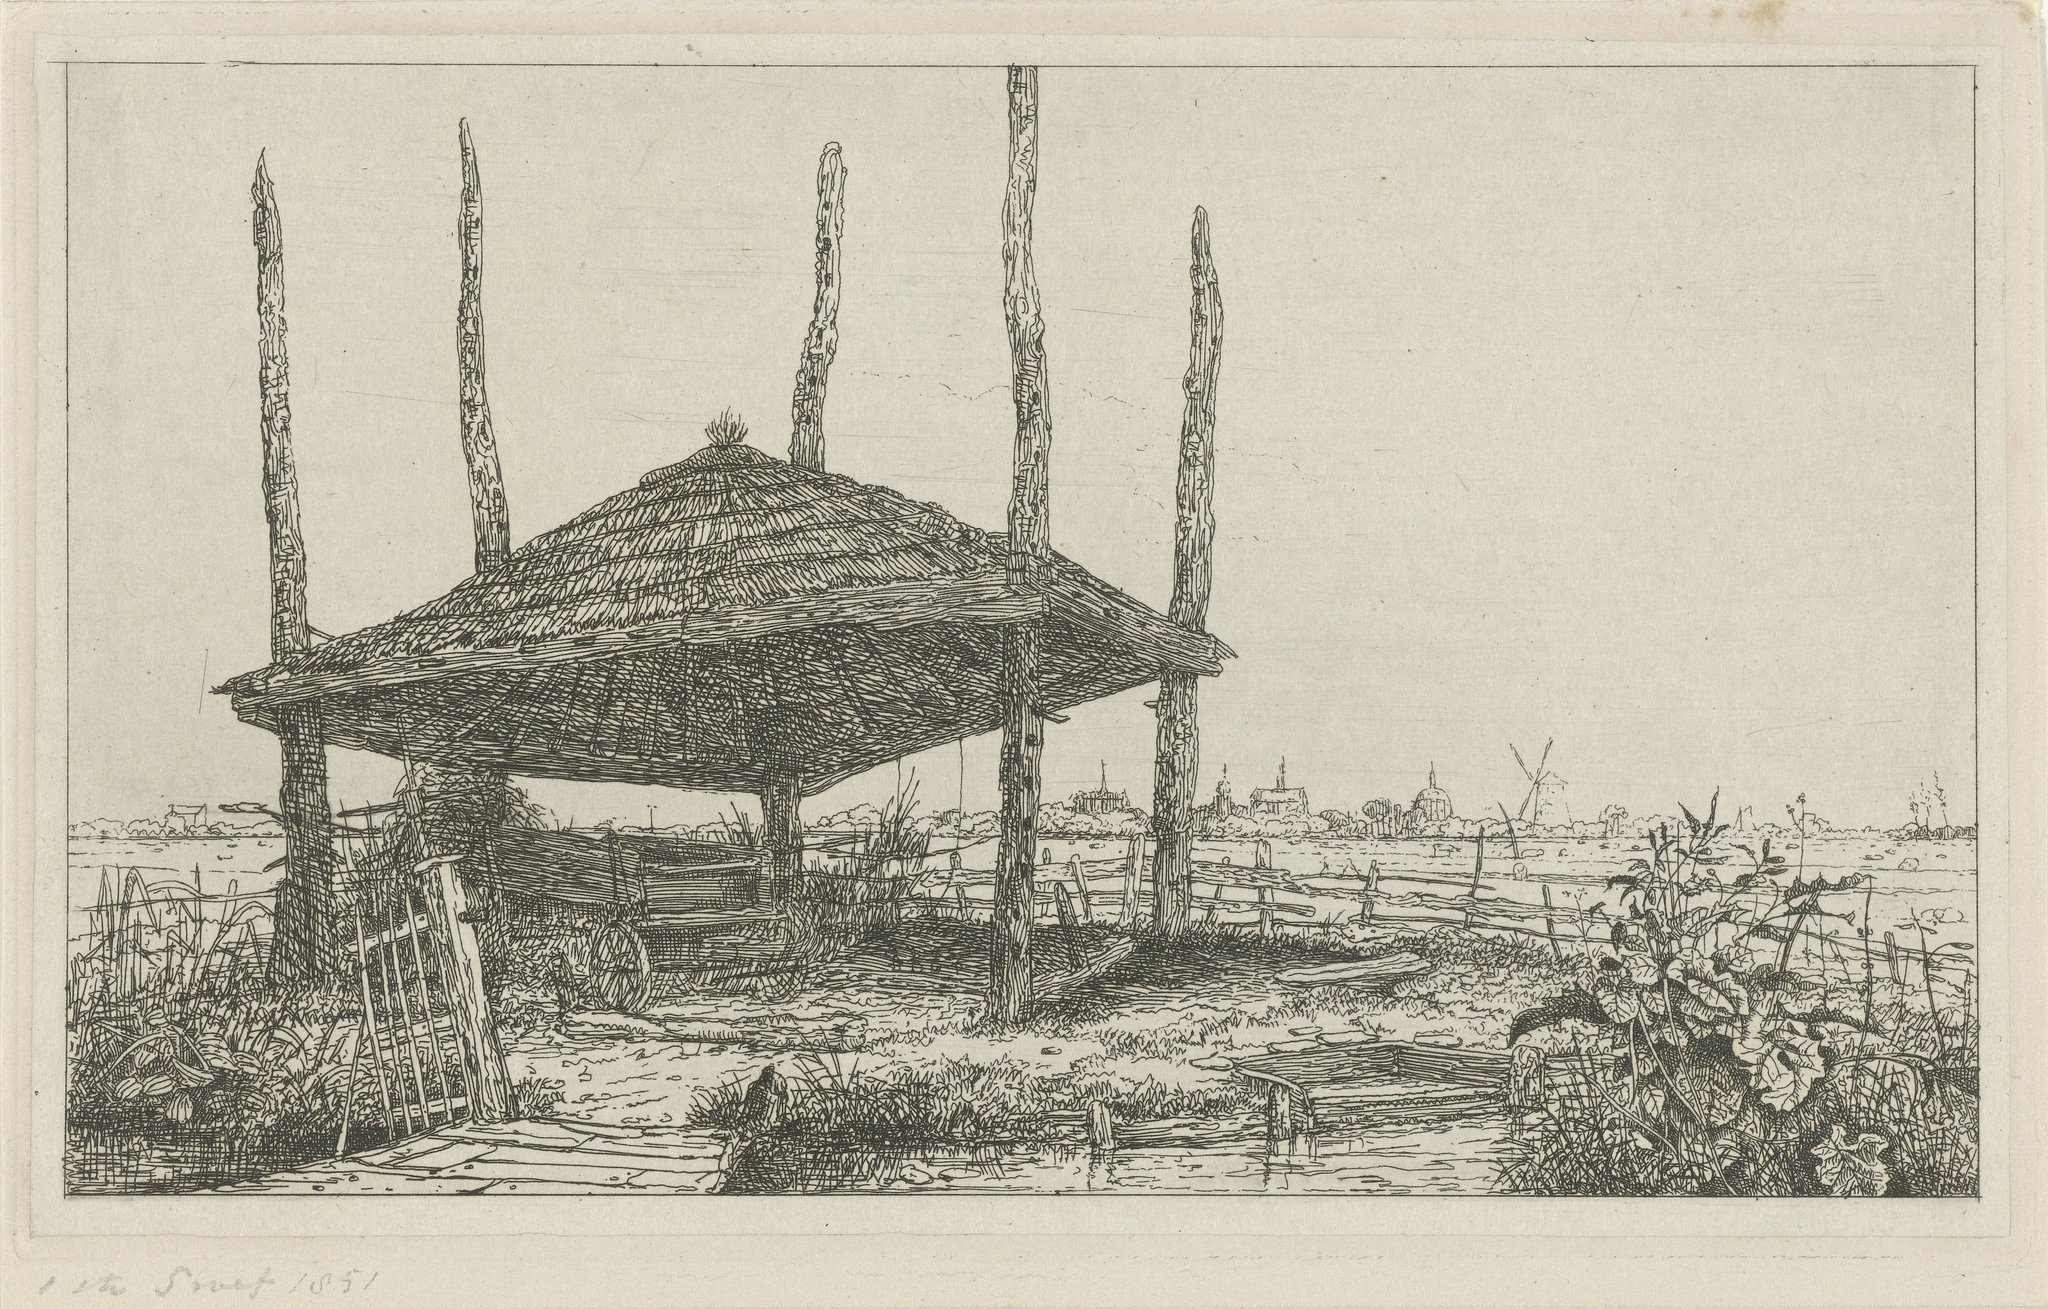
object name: print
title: Landschap met een lege hooiberg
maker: jacobus ludovicus cornet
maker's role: draughtsman, print maker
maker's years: 1815-1882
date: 1851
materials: paper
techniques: etching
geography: leiden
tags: hay-stack, prospect of city, town panorama, silhouette of city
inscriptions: collector's mark: Lugt 2228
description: Landschap met een lege hooiberg. Op de voorgrond een brug over een beekje. Op de achtergrond de contouren van een stad.